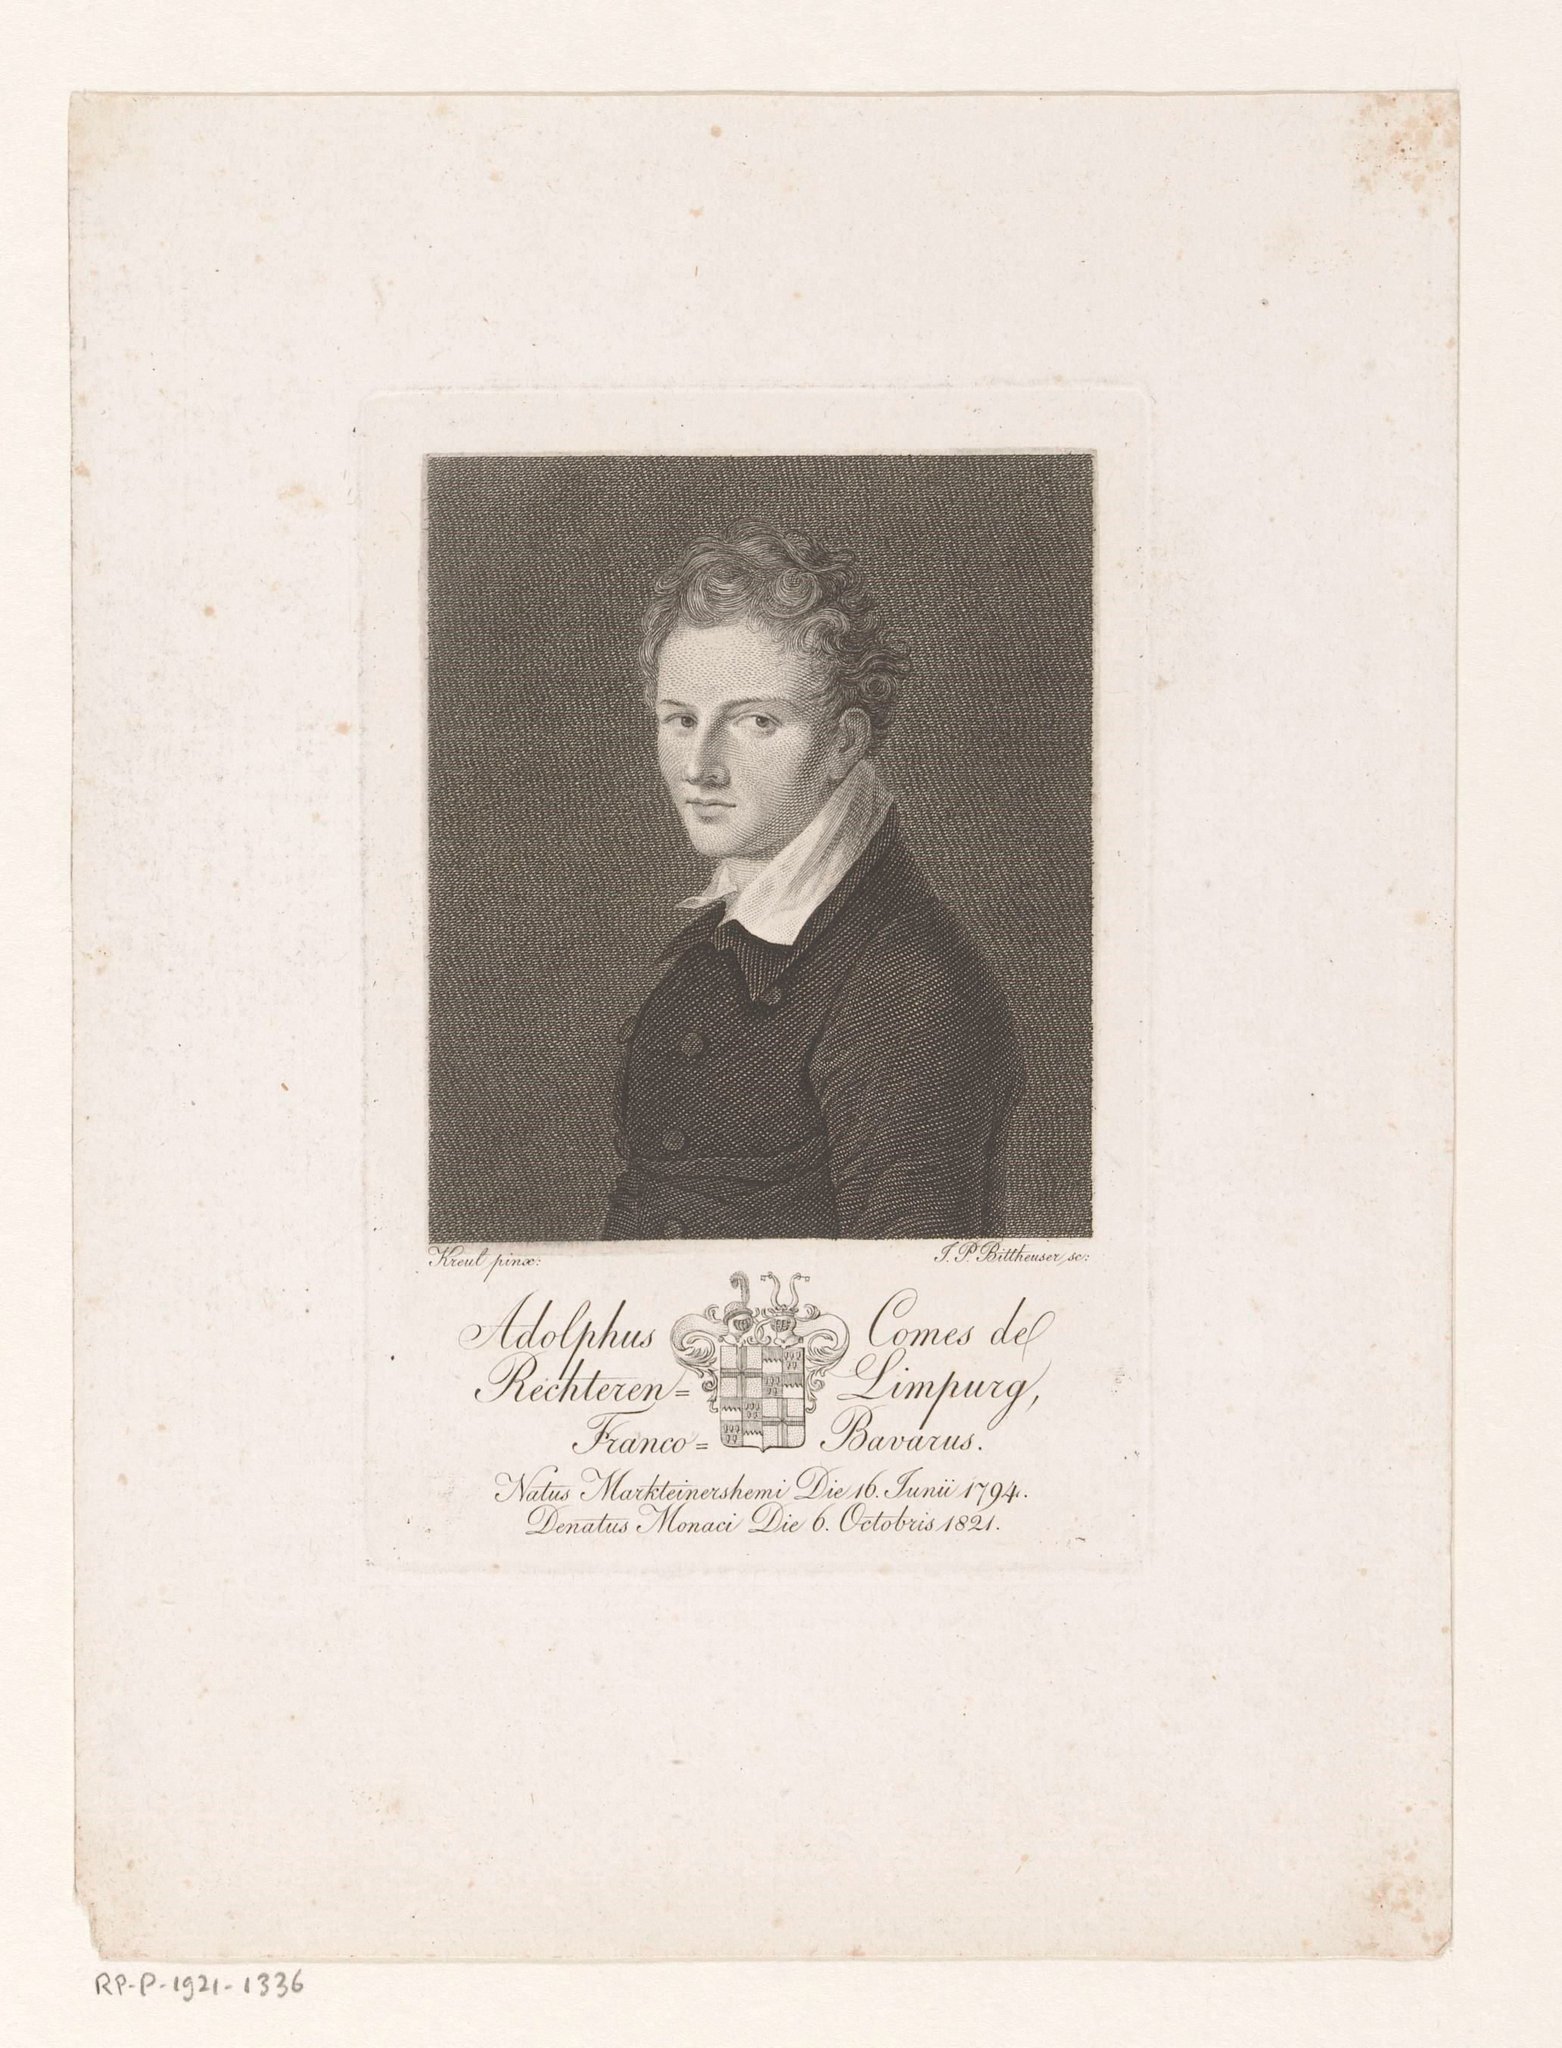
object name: print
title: Portret van Adolph von Rechteren-Limpurg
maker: johann pleikhard bittheuser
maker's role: print maker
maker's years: 1774-1859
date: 1821-1859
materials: paper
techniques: engraving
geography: würzburg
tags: historical persons, armorial bearing, heraldry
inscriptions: collector's mark: Lugt 2233